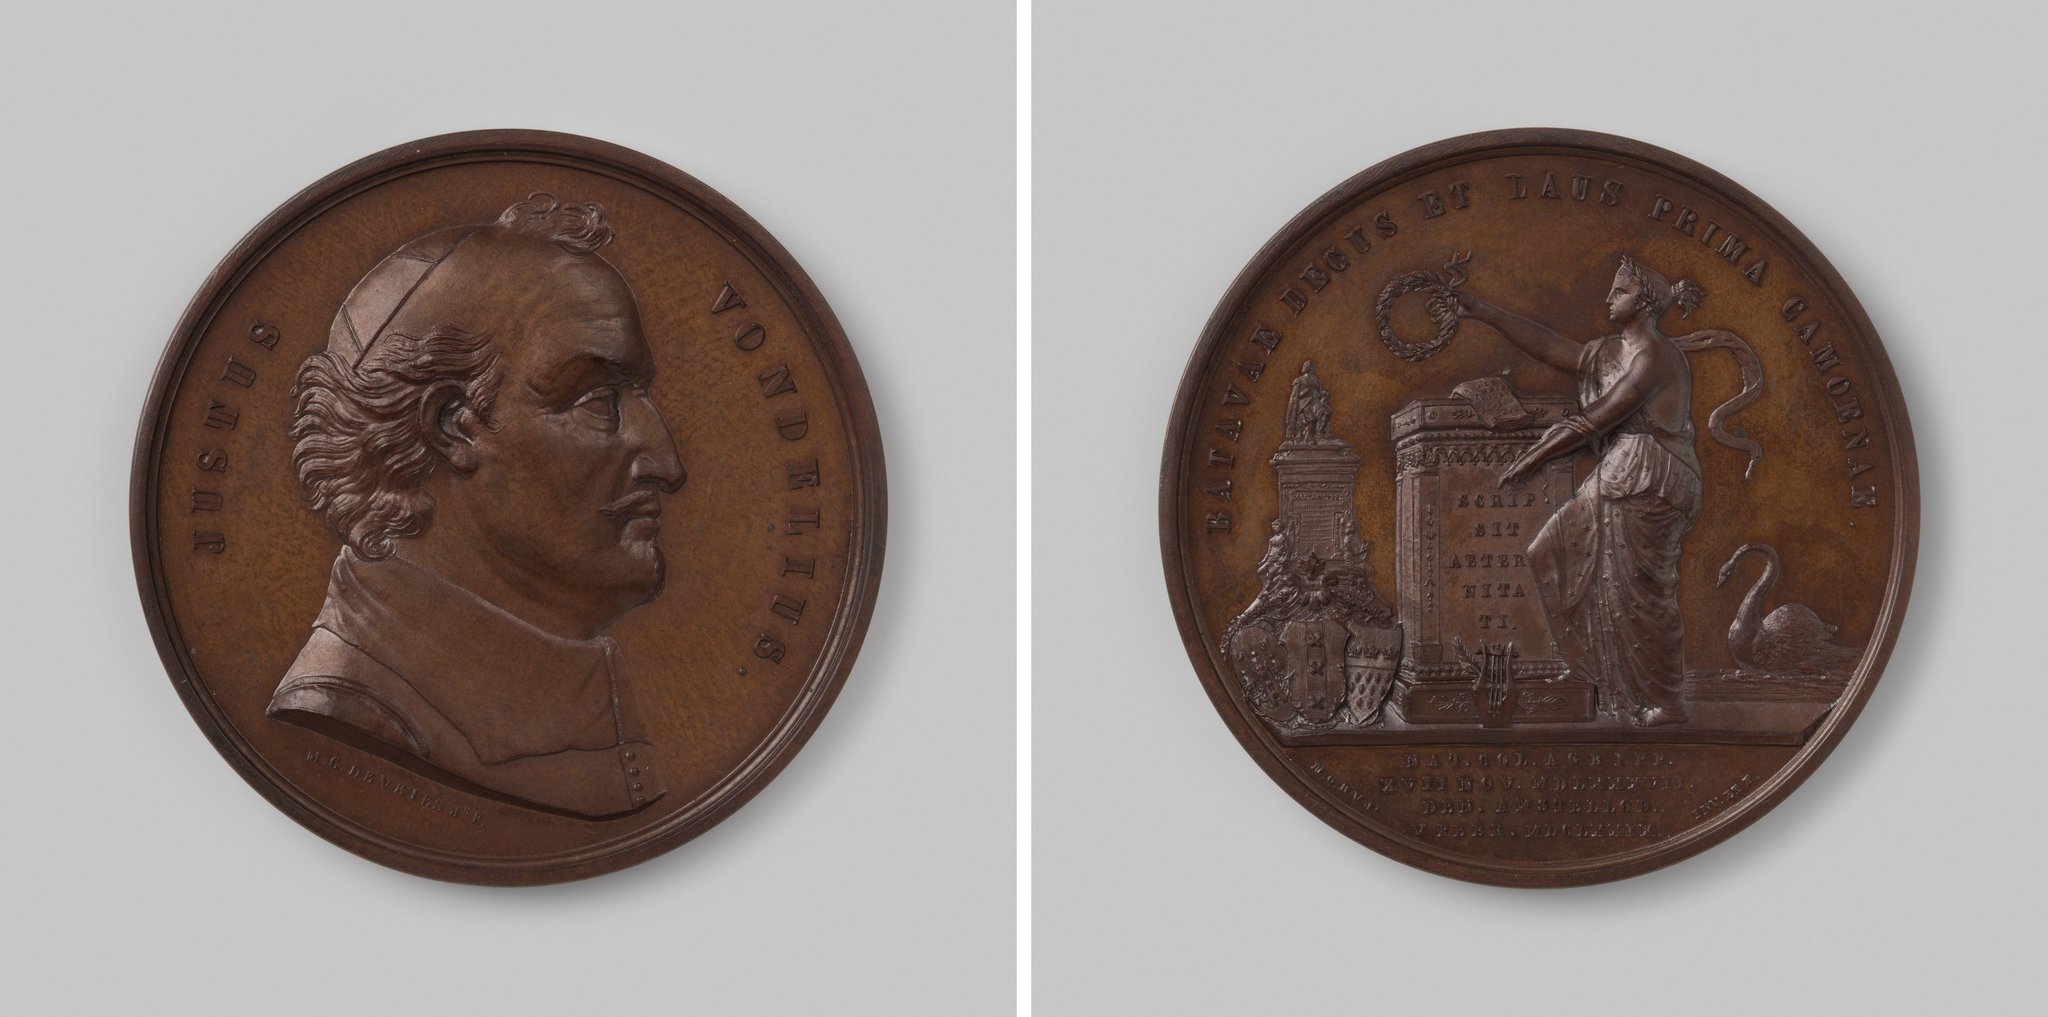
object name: history medal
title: Joost van den Vondel 1867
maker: moses cohen de vries junior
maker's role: diamantslijper, graveur, medailleur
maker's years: 1807-1883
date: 1867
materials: bronze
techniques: striking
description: Bronzen penning, op de voorzijde het borstbeeld van Vondel naar rechts met omschrift, op de keerzijde de Dichtkunst naast een altaar met boekrol, die Vondels standbeeld lauwert, met rechts een zwaan, met omschrift en afsnedetekst.